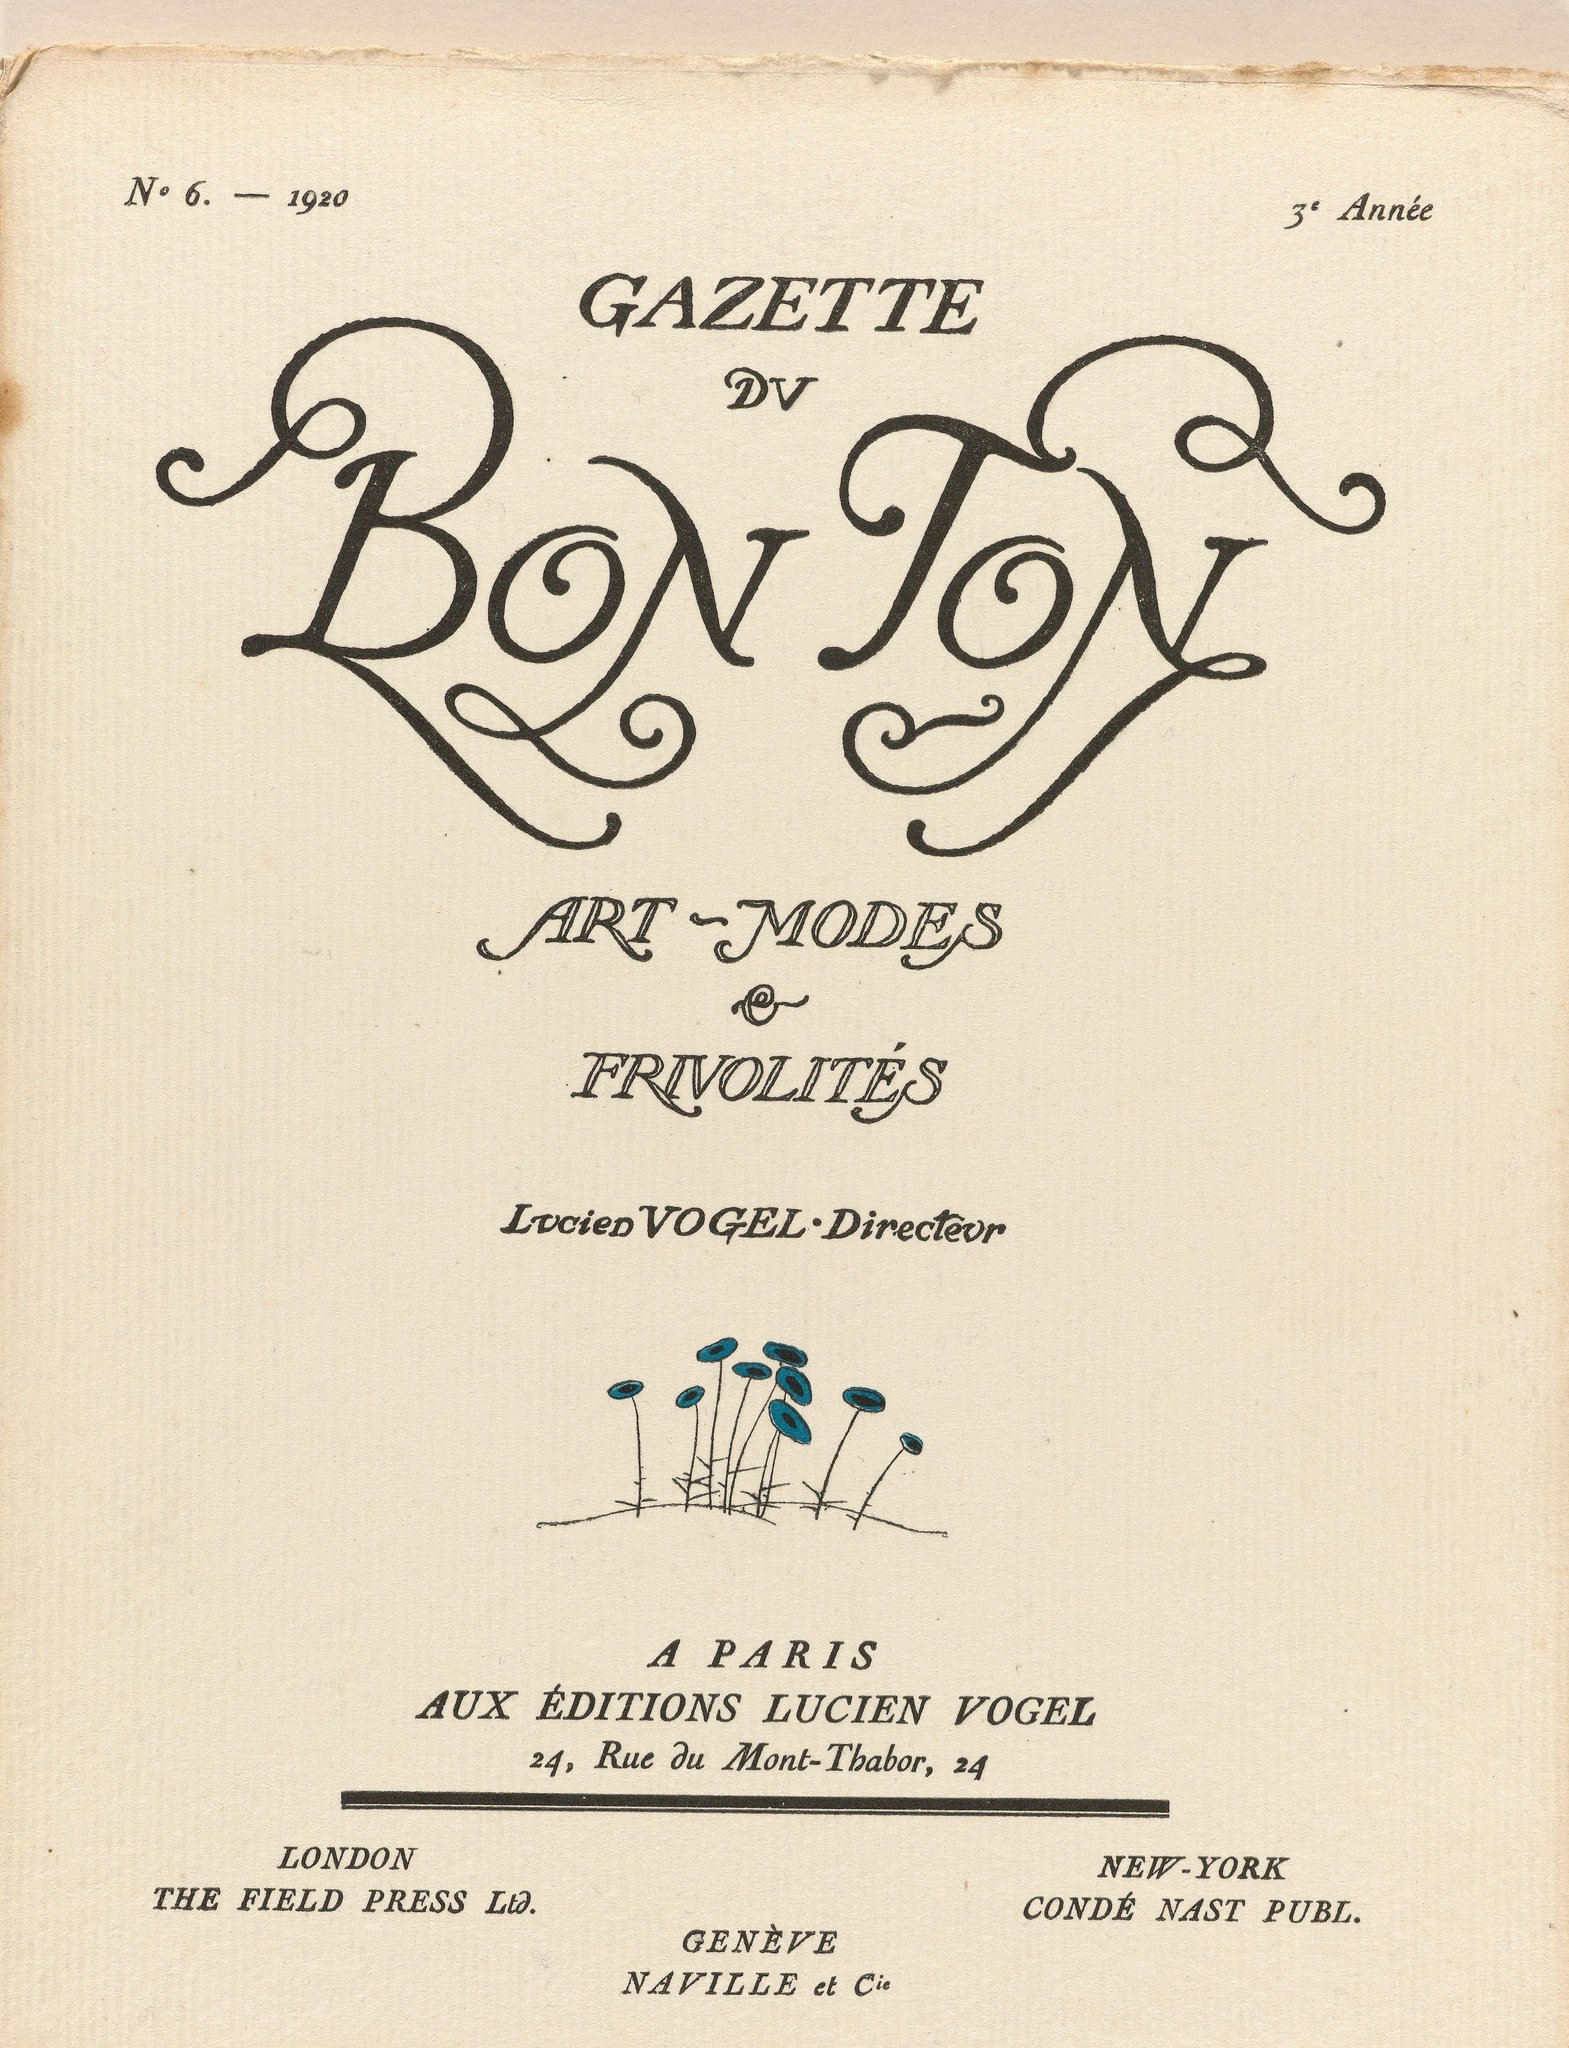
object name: fashion print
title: Gazette du Bon Ton. Art - Modes & Frivolités, 1920, 3e Année, No.6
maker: lucien vogel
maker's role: publisher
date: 1920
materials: paper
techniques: letterpress printing, pochoir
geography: paris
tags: fashion plates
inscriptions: date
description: Aflevering No. 6, juli 1920, van Gazette du Bon Ton, bestaand uit een omslag, negen katernen met tekst en illustraties en twaalf losse prenten. Aan dit deel werkten de volgende modeontwerpers mee: Beer, Cheruit, Doeuillet, Doucet, Lanvin, Paquin, Paul Poiret, Redfern en Worth.